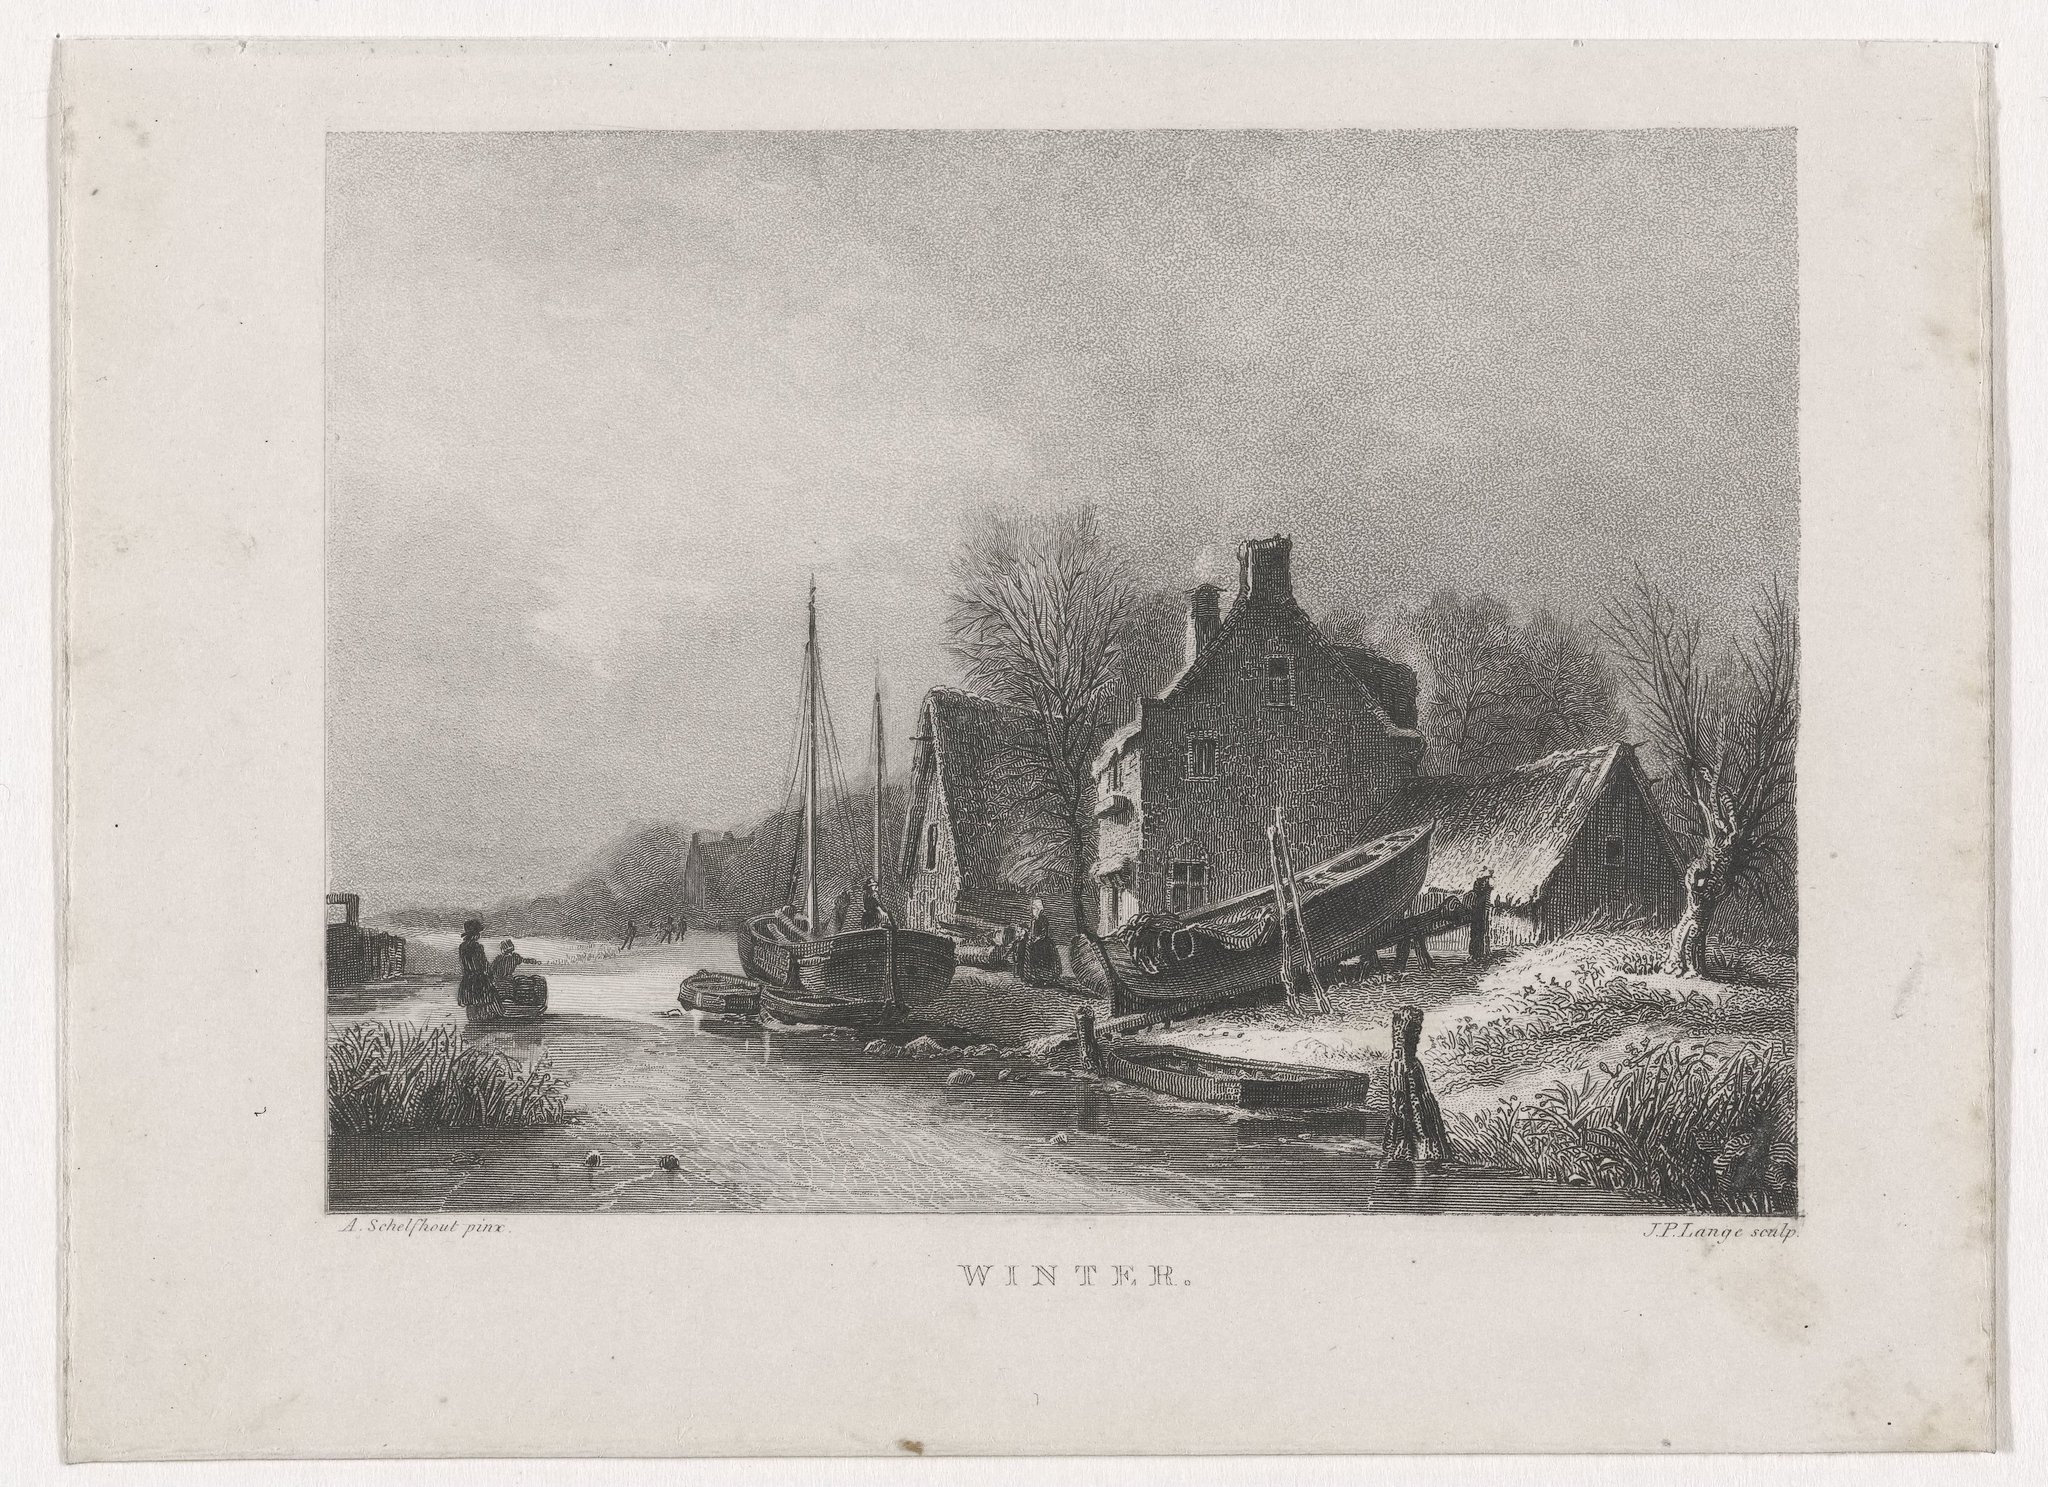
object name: print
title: Winter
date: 1839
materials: paper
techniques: engraving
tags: sleigh, sledge (non-sport), winter landscape; landscape symbolizing winter (the four seasons of the year), ships, boats on land, beached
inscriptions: collector's mark: Lugt 2228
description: Wintergezicht met figuren op het ijs. Rechts ligt voor een huis een boot op het droge.